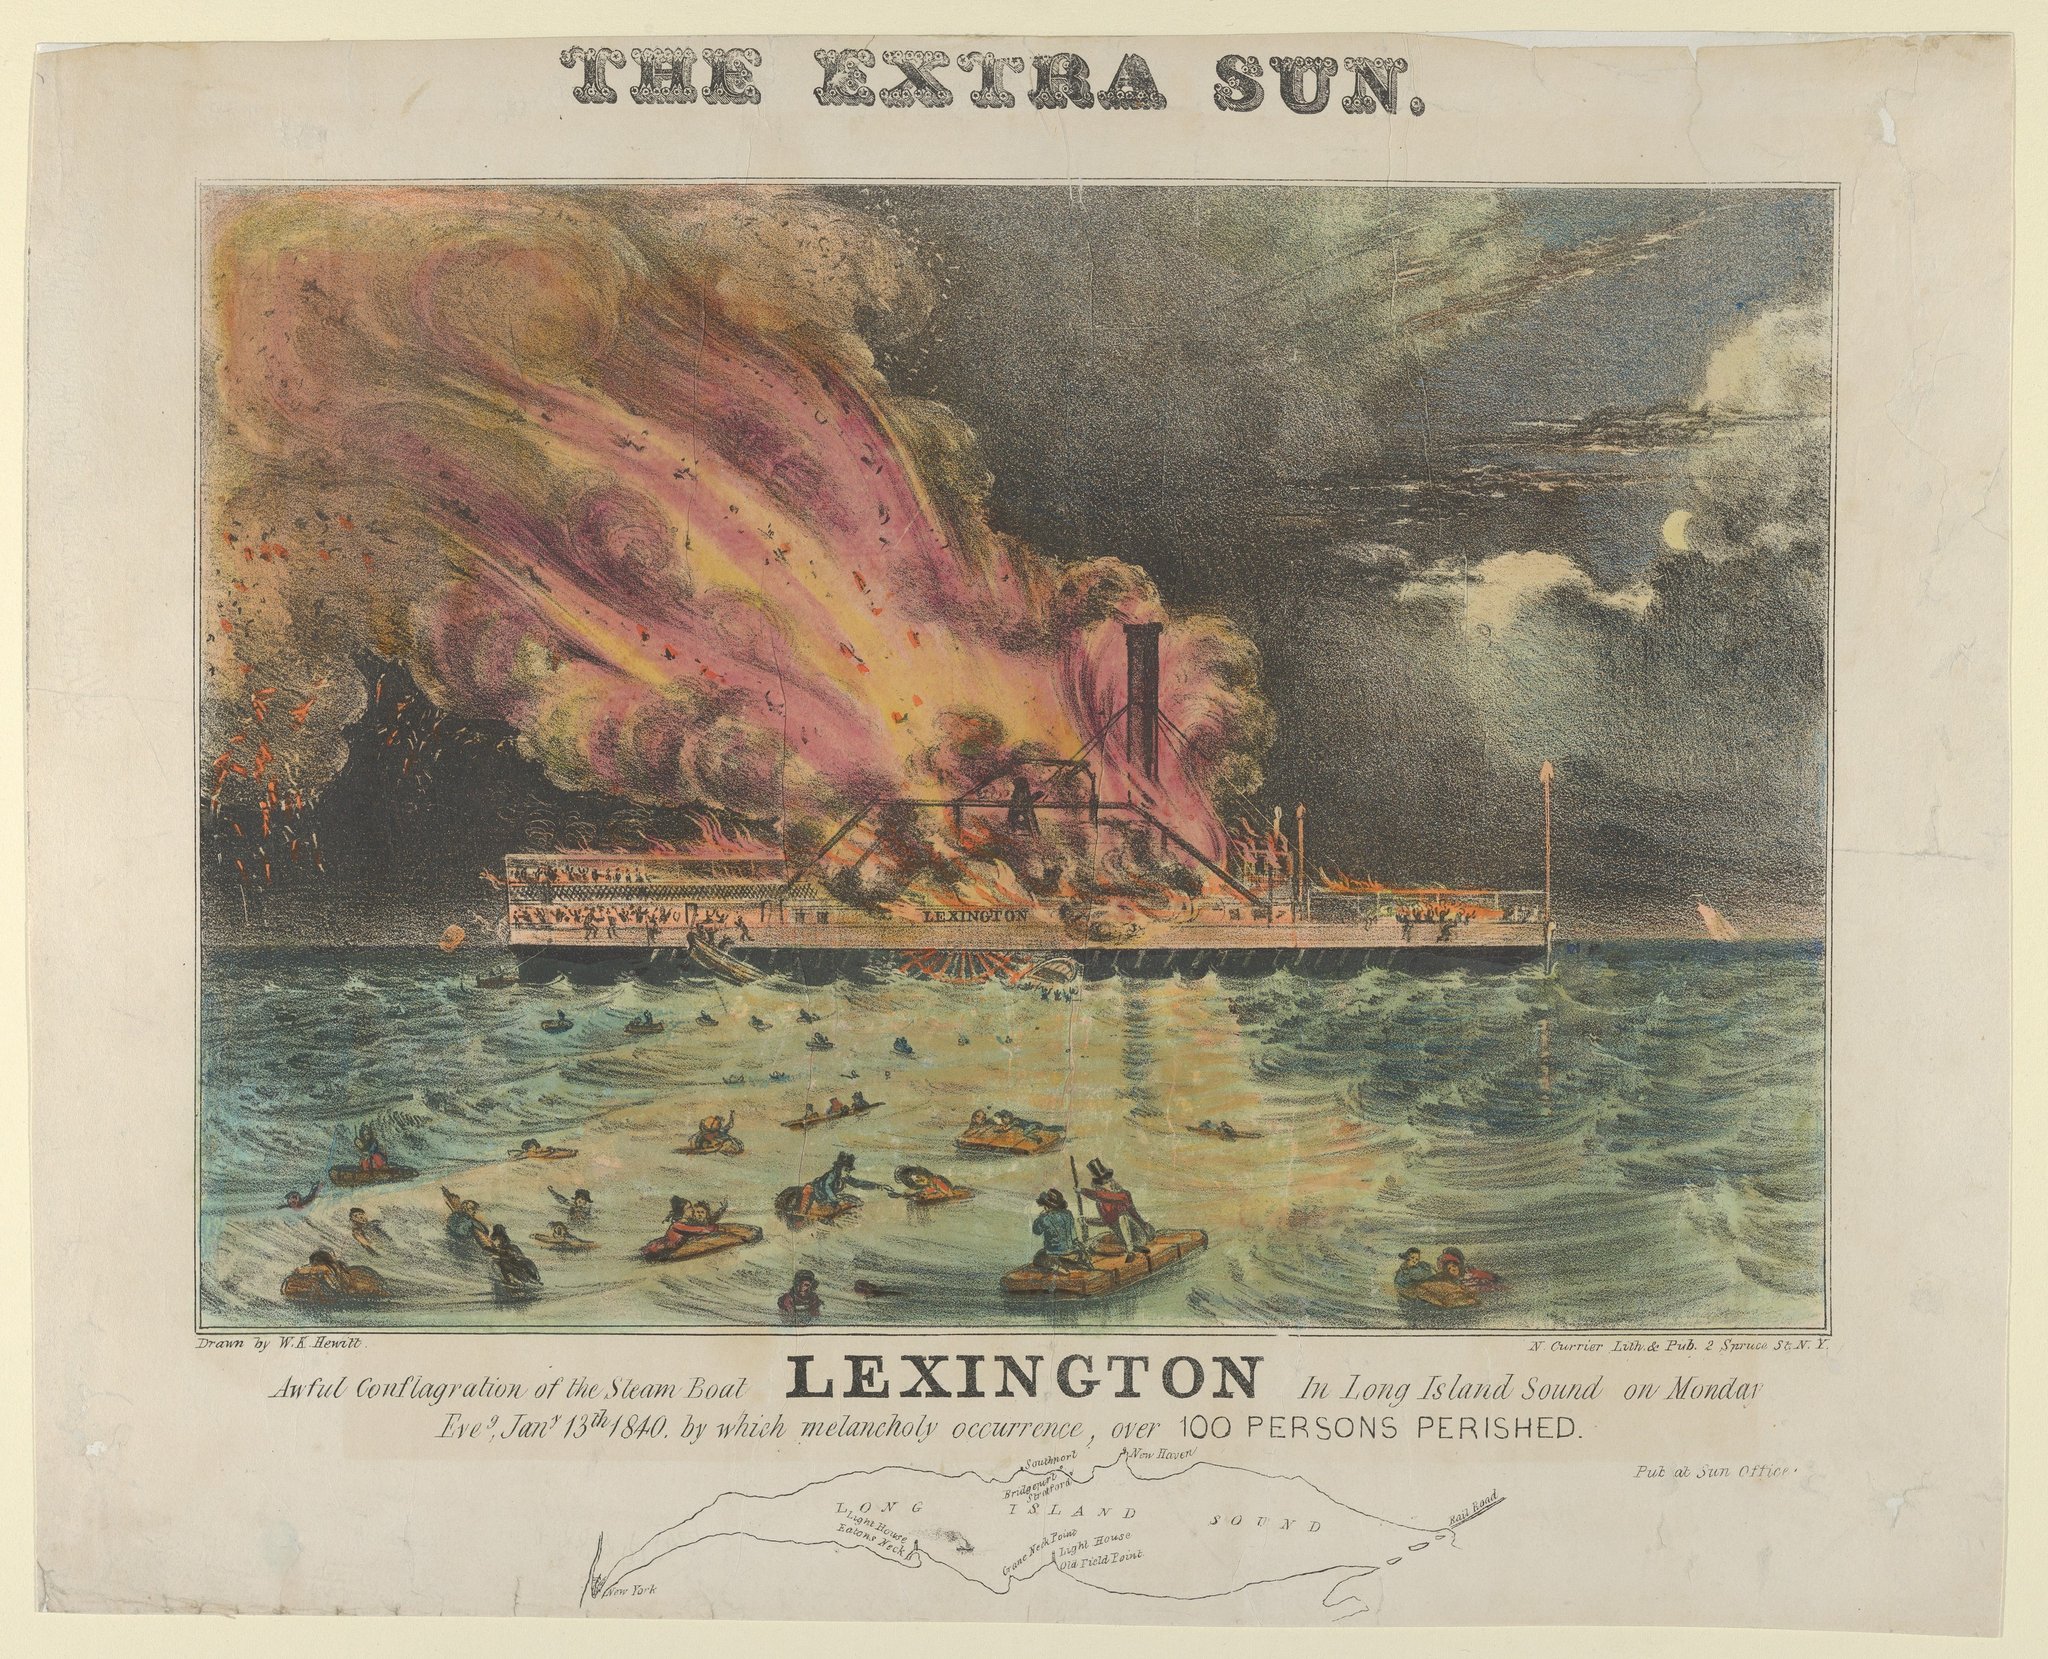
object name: print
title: Awful Conflagration of the Steam Boat Lexington in Long Island Sound on Monday Eve, January 13th, 1840, by which melancholy occurrence, over 100 Persons Perished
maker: william keesey hewitt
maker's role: artist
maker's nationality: american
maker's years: 1817-1893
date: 1840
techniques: hand coloring, lithograph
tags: human figures,fire,boats,ships